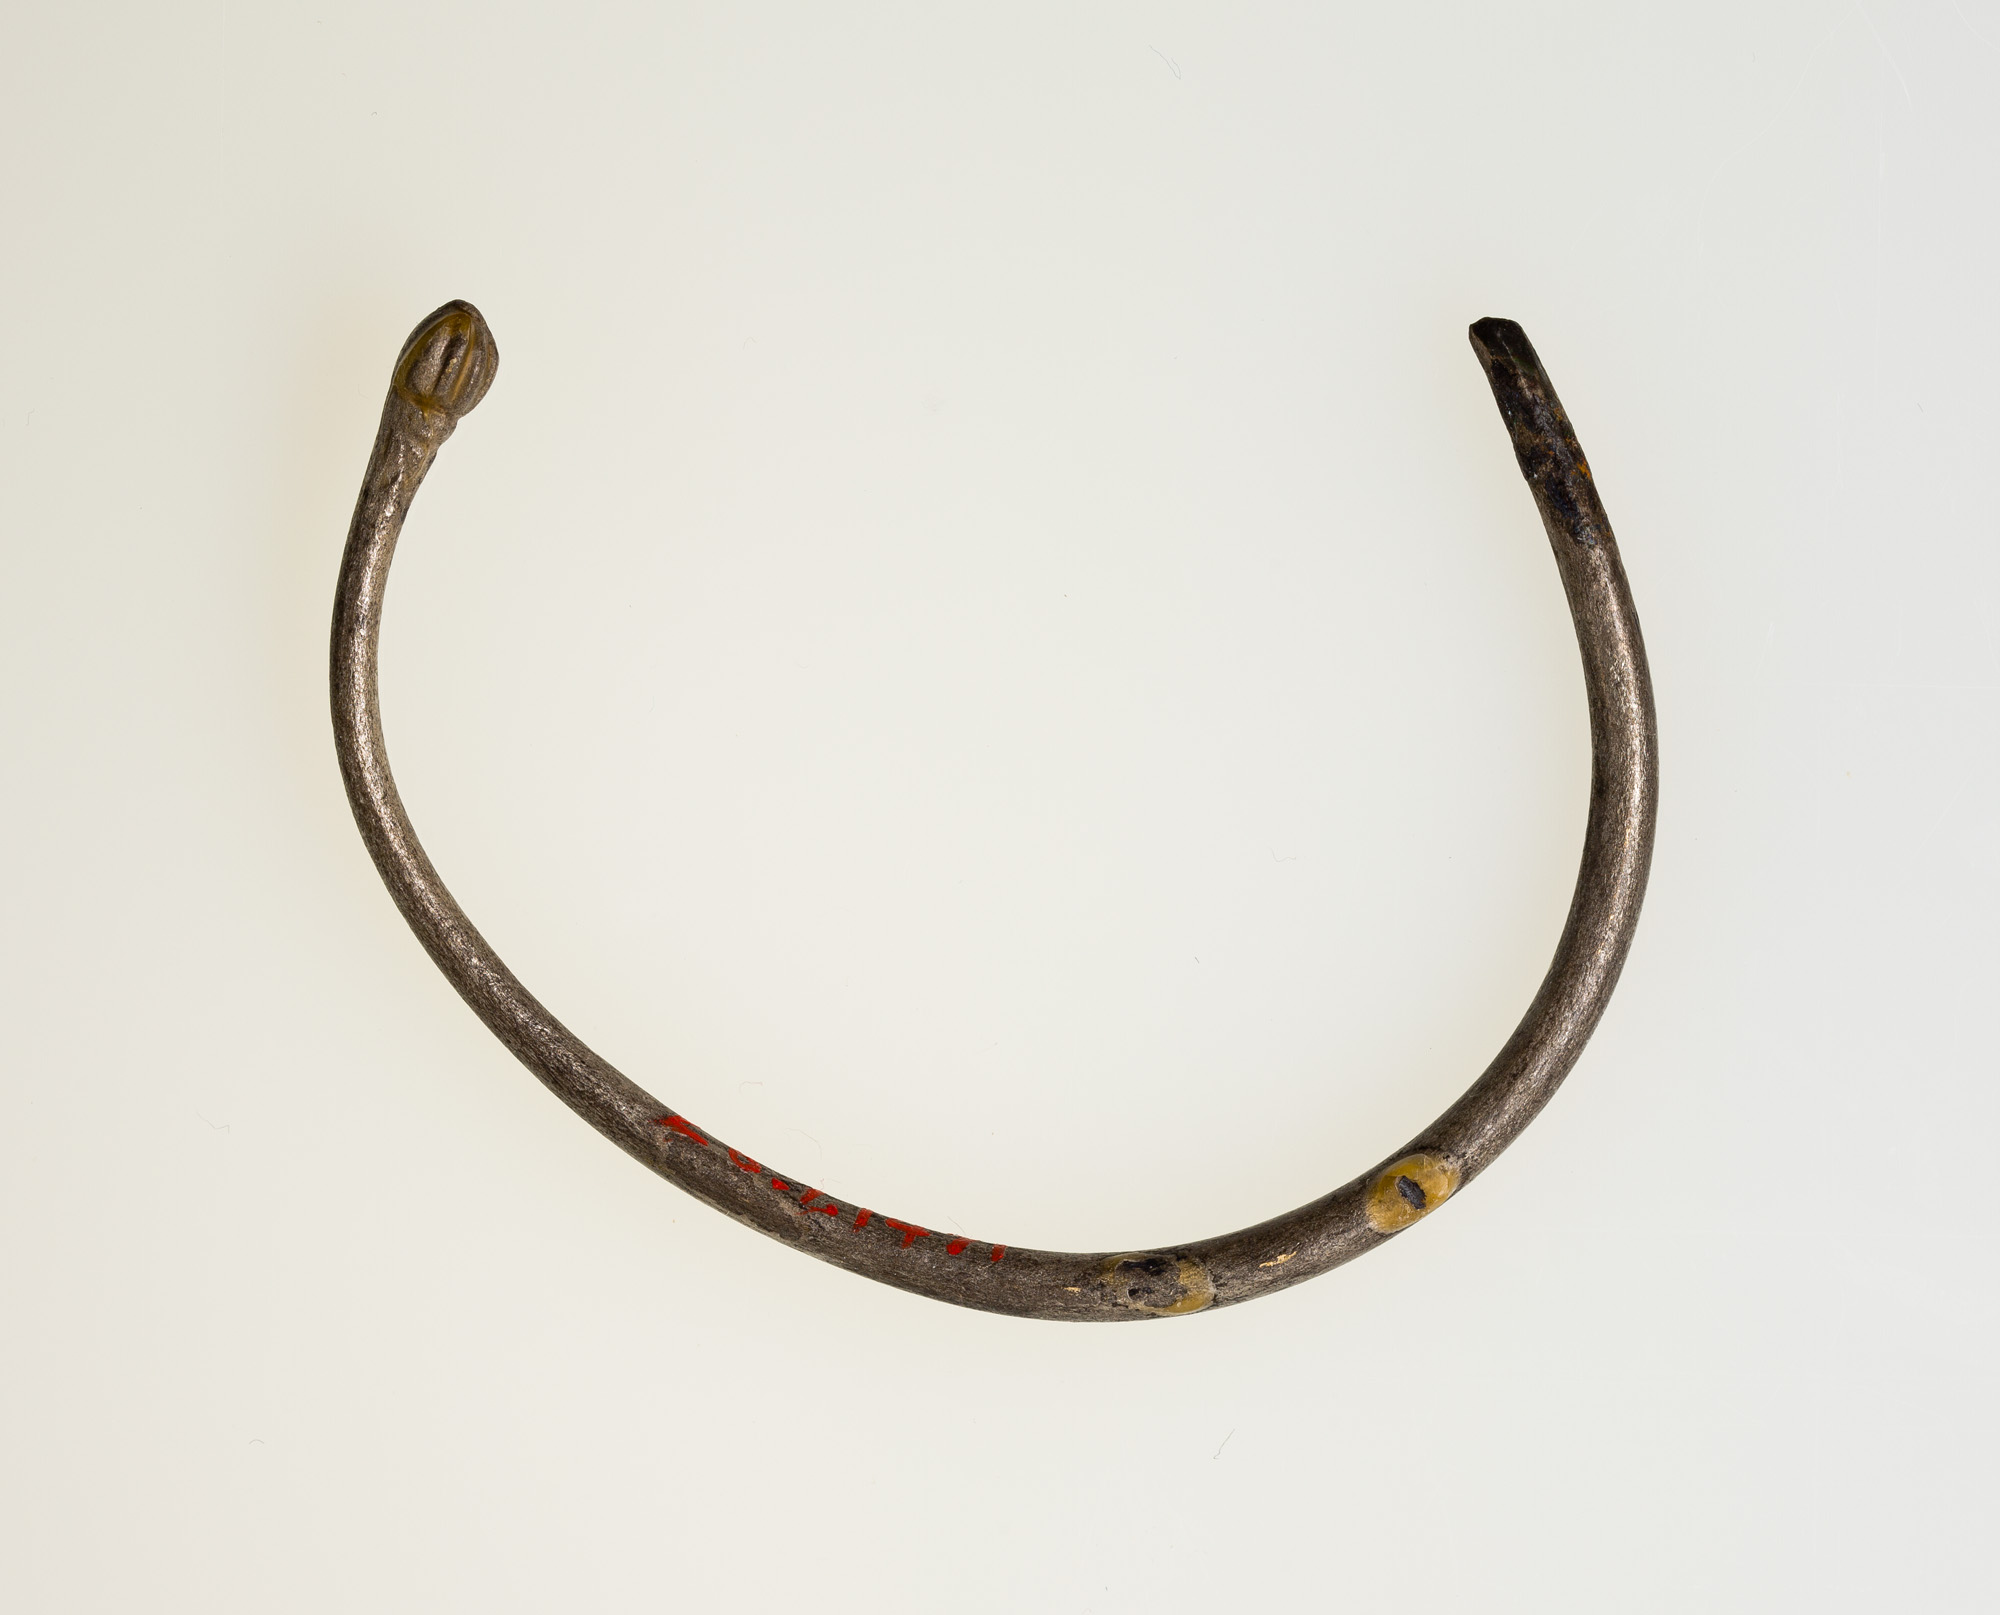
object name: bracelet bangle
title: Bangle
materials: silver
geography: egypt